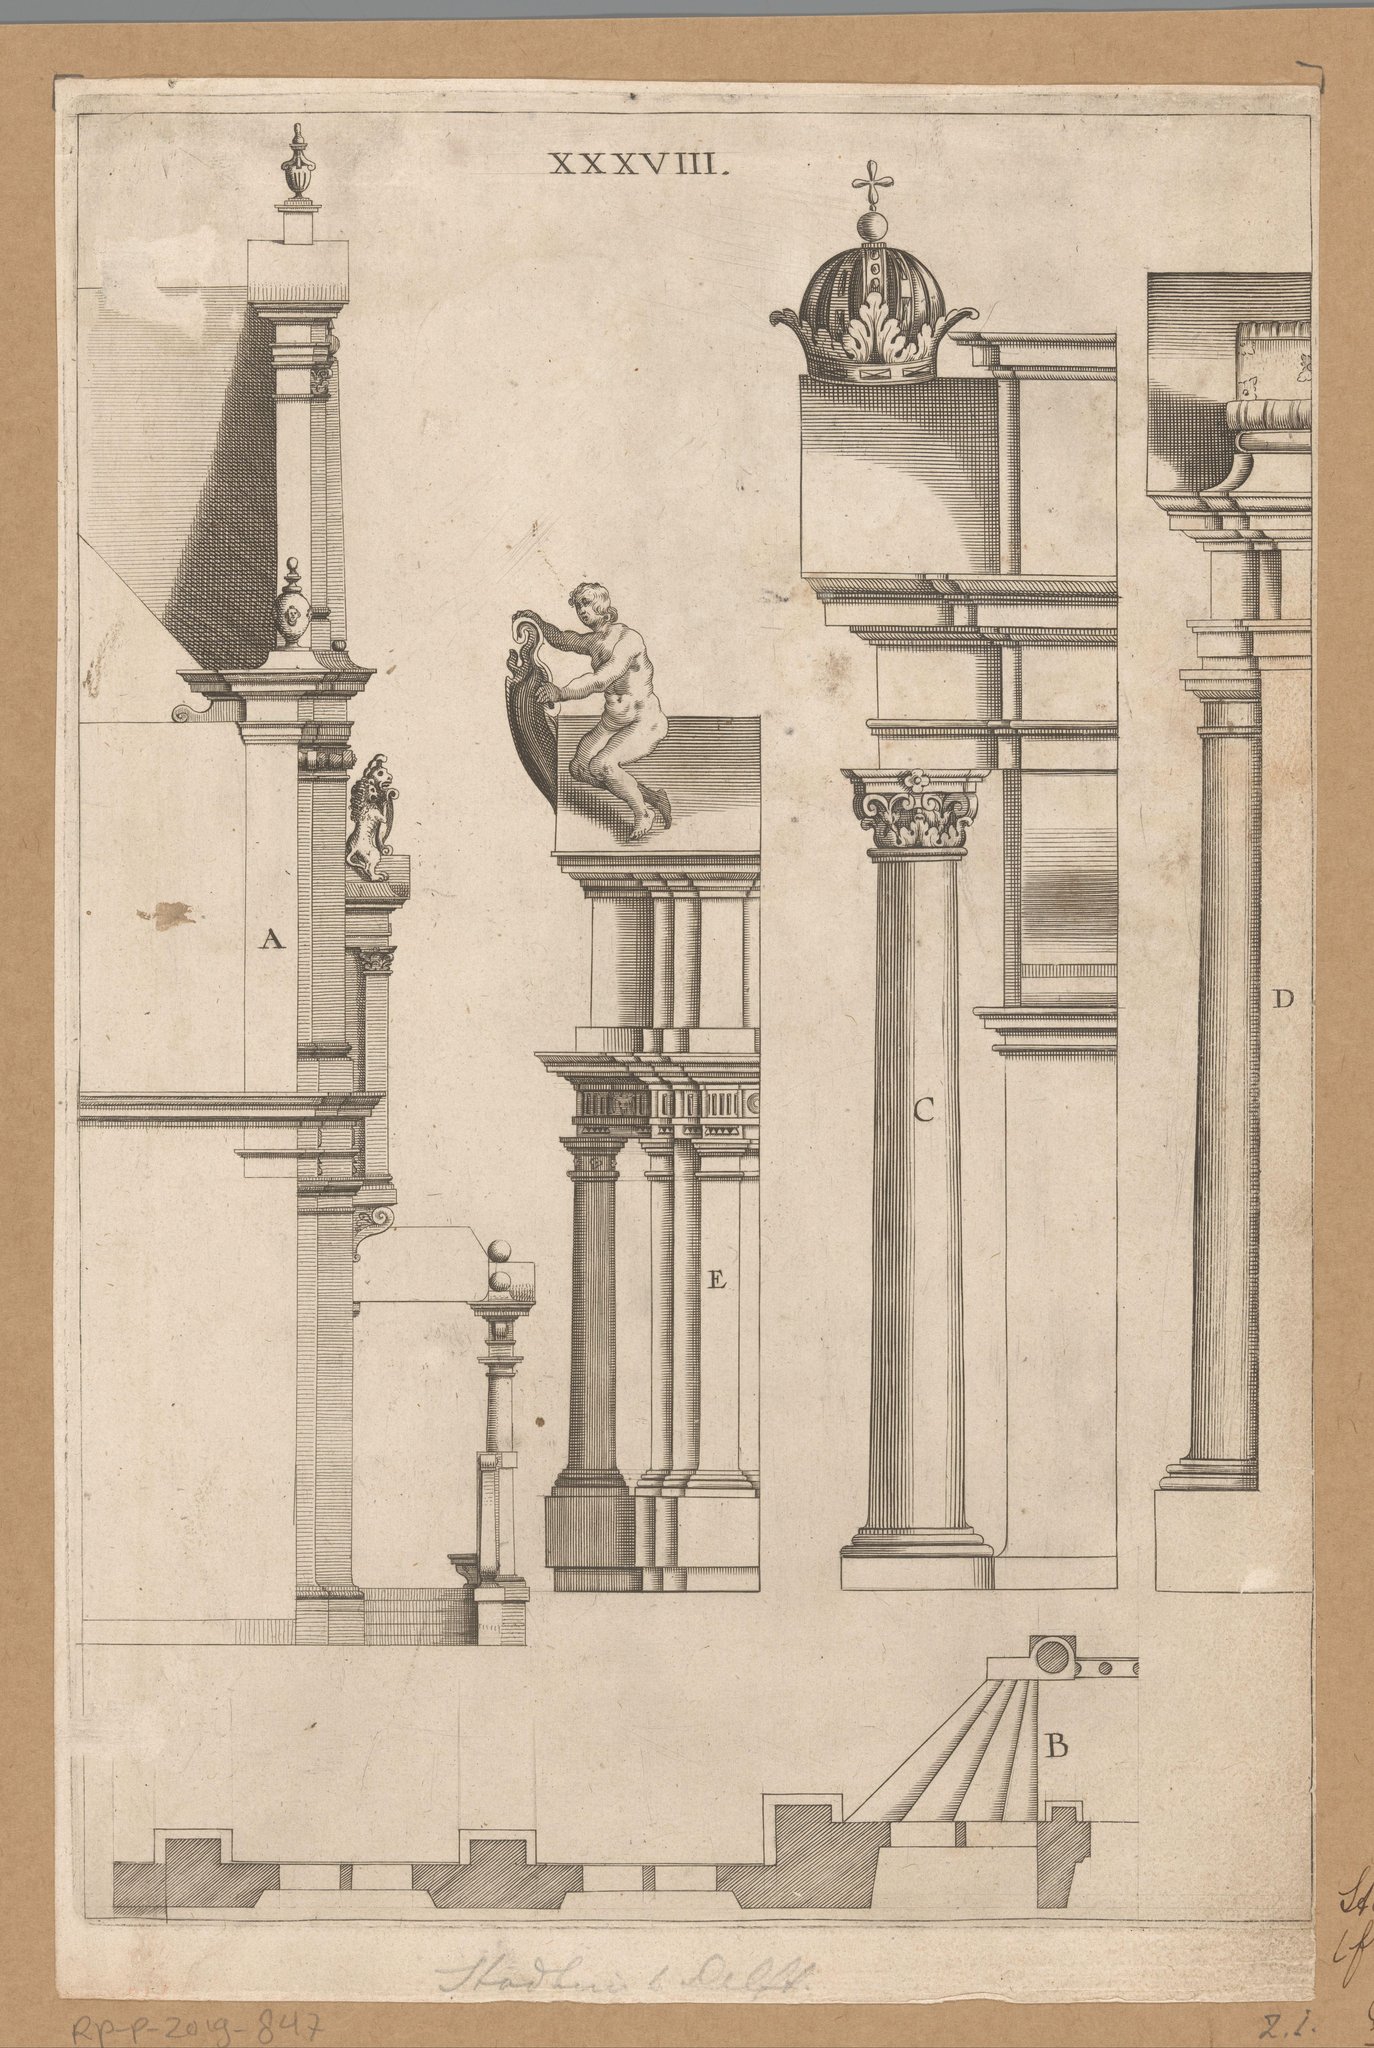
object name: print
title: Delen van het stadhuis van Delft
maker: Anonymous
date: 1670-1730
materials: paper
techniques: engraving, etching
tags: architectural detail, townhall, half-column, pilaster ~ architecture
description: Architecturale details van het stadhuis van Delft. De vijf details zijn gemerkt met de letters A tot en met E. Bovenin genummerd: 38.